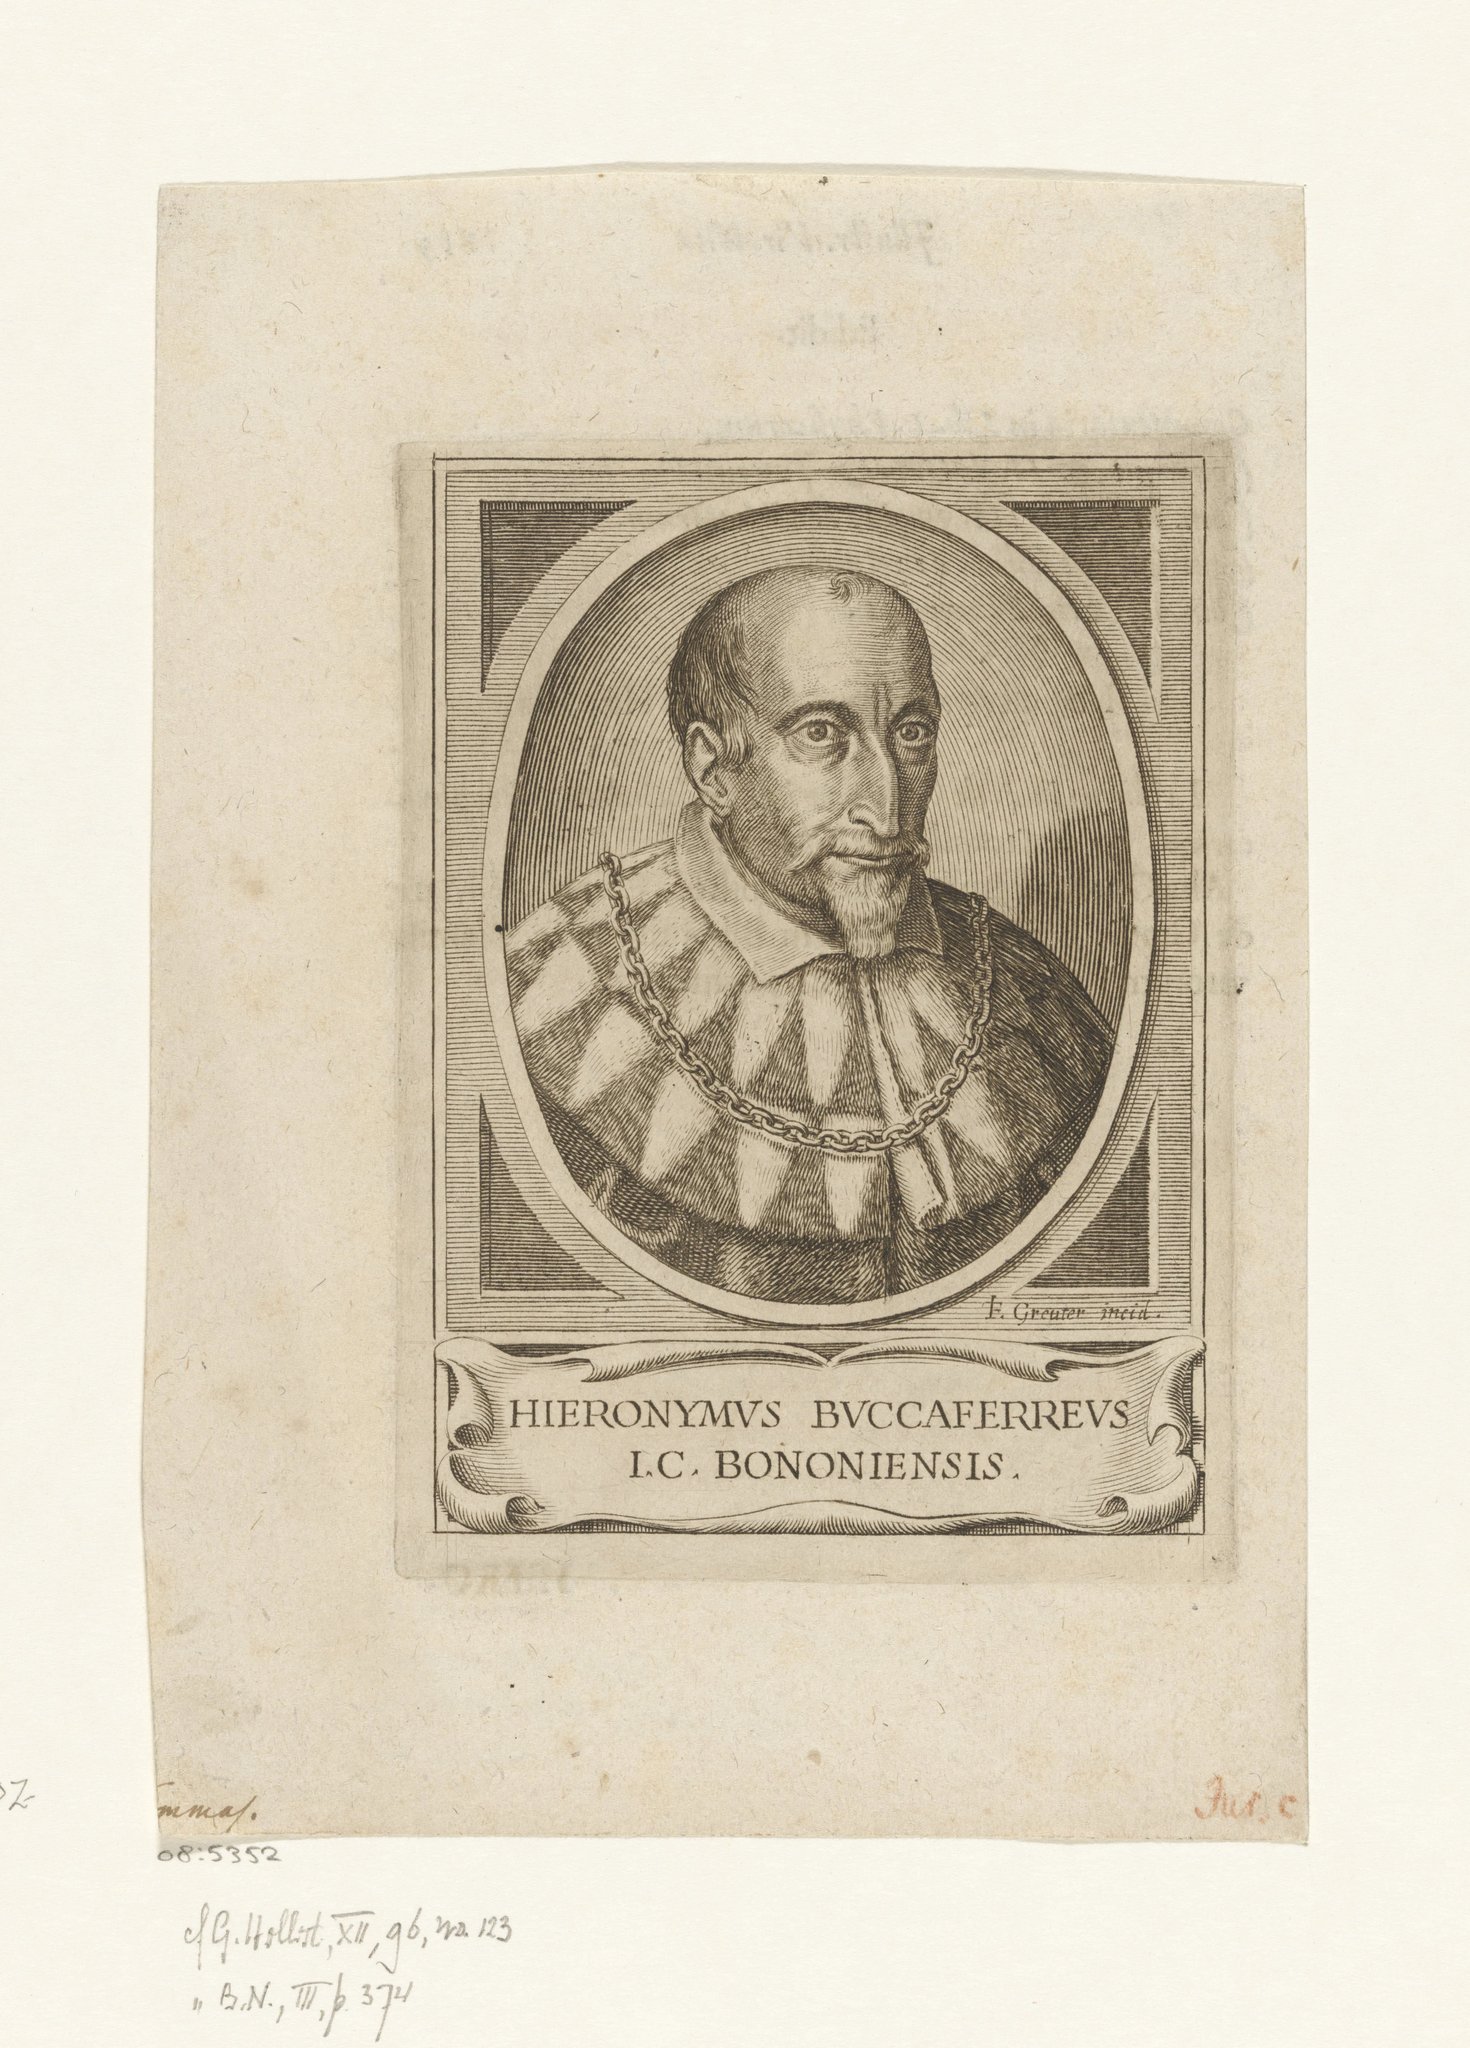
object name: print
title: Portret van Hieronymus Buccaferreus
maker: johann friedrich greuter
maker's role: print maker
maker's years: 1589-1662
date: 1599-1662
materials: paper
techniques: engraving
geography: italy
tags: historical persons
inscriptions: collector's mark: Lugt 2228